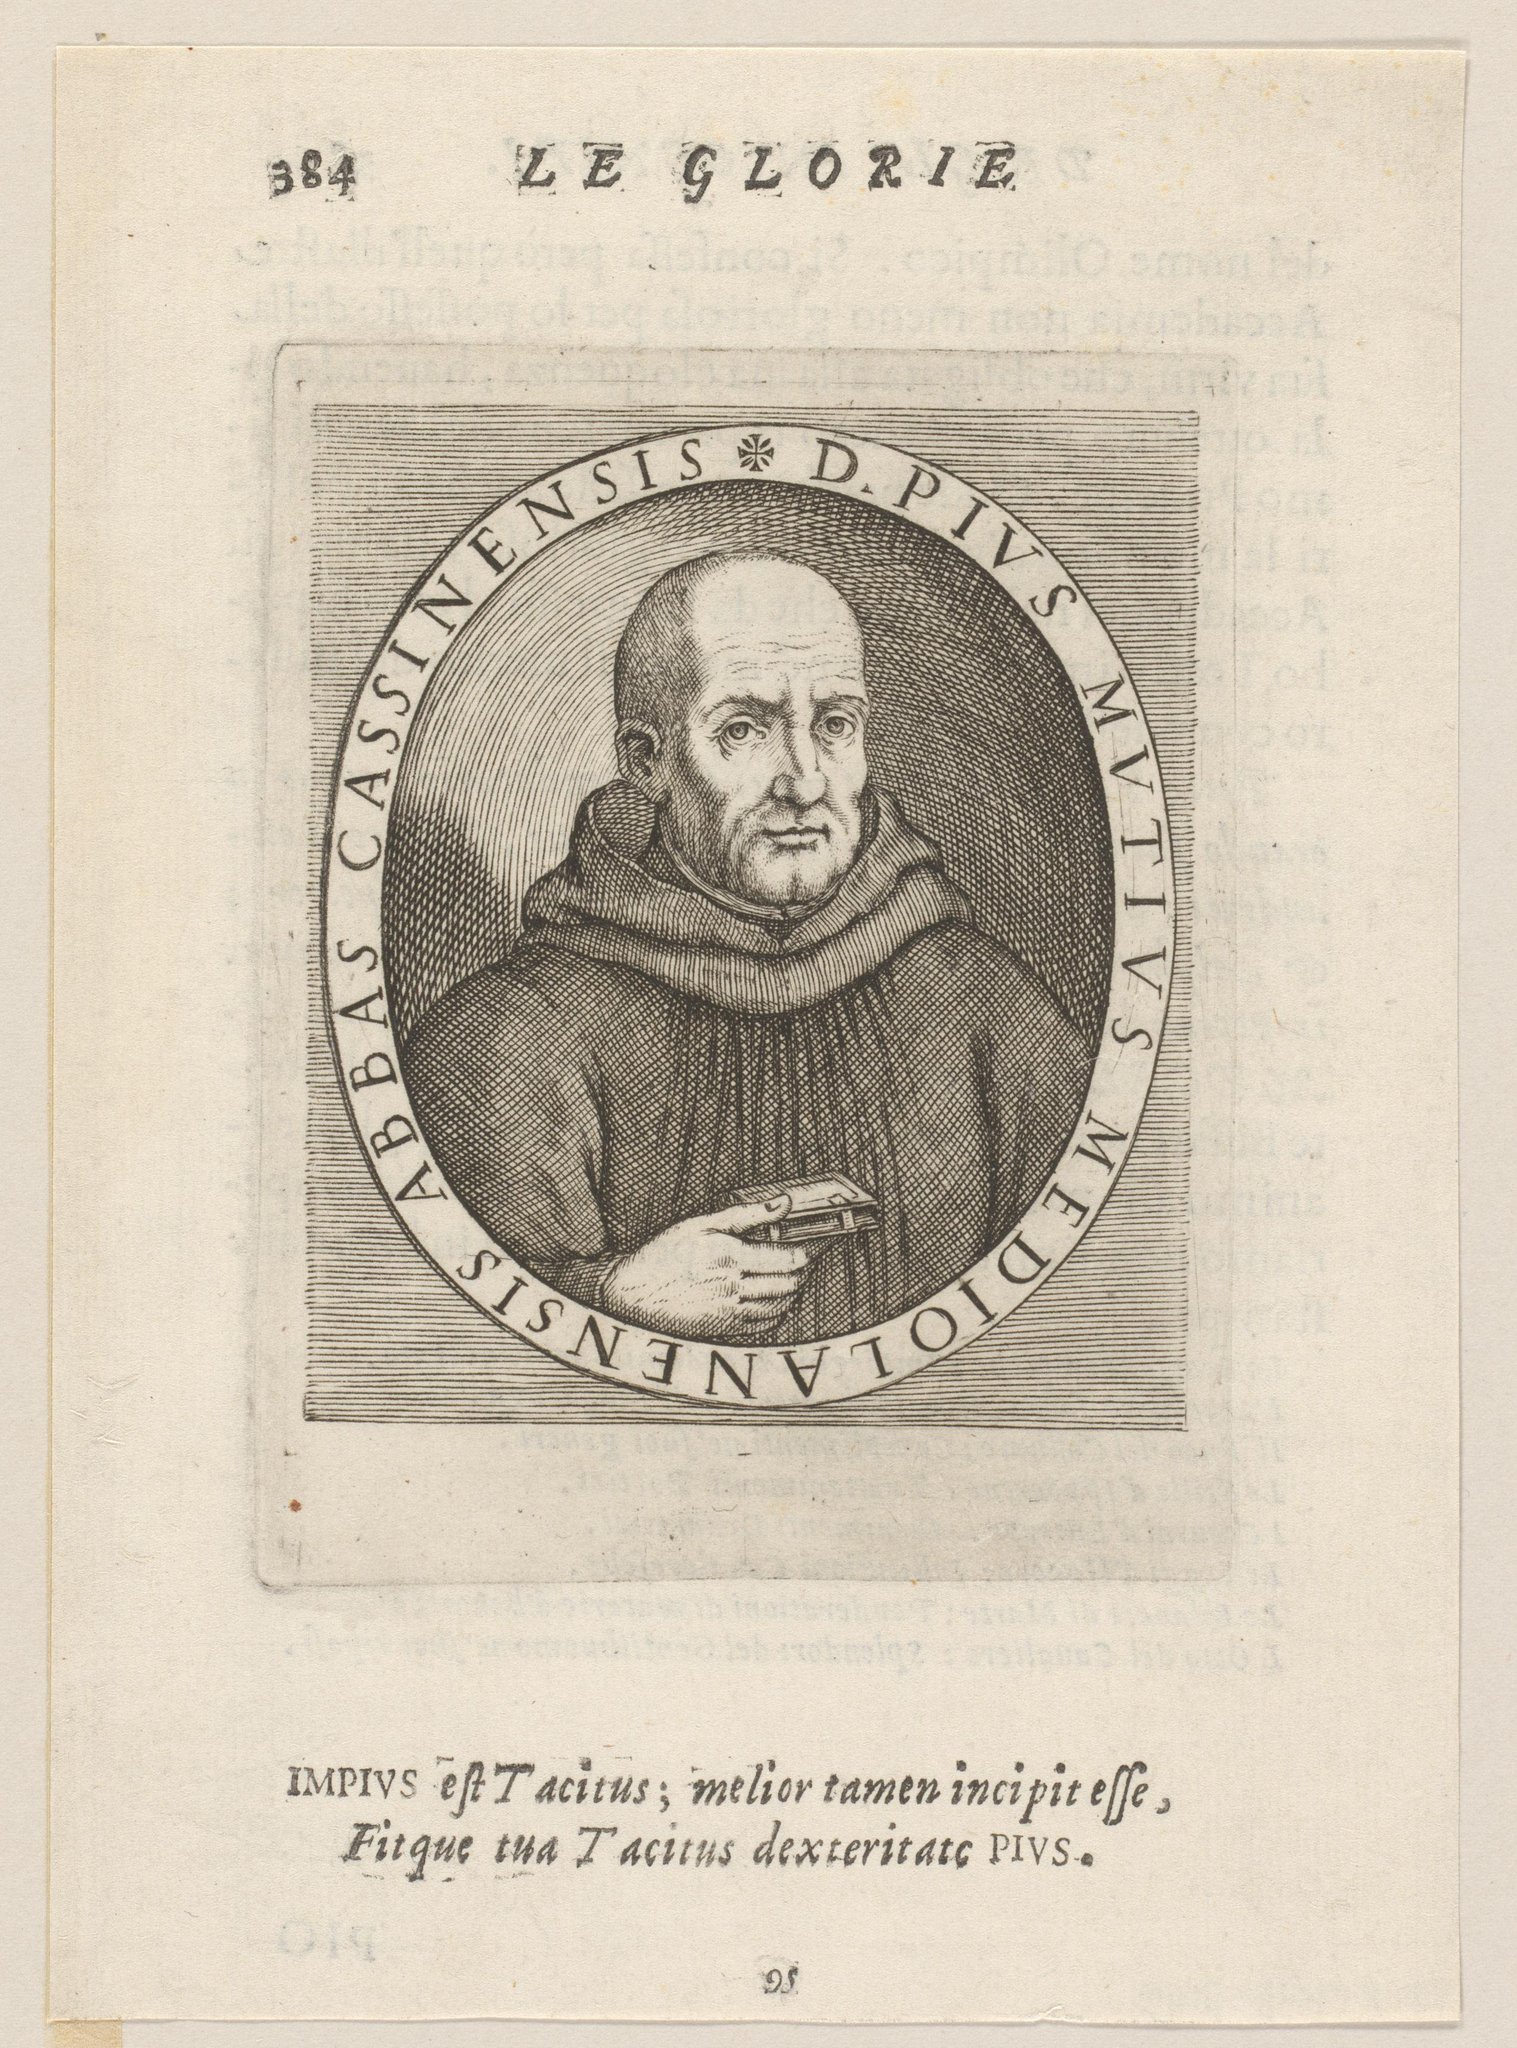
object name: print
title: D. Pius Mutius Mediolanensis abbas cassinensis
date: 1647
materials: paper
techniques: engraving, letterpress printing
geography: venice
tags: historical persons, organization, functionaries and dignitaries in roman catholic church; clergy in general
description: Prent uit: Le glorie degli Incogniti o vero gli huomini illustri dell'accademia de signori Incogniti di Venetia. Venetië: Francesco Valvasense, 1647, p. 384.